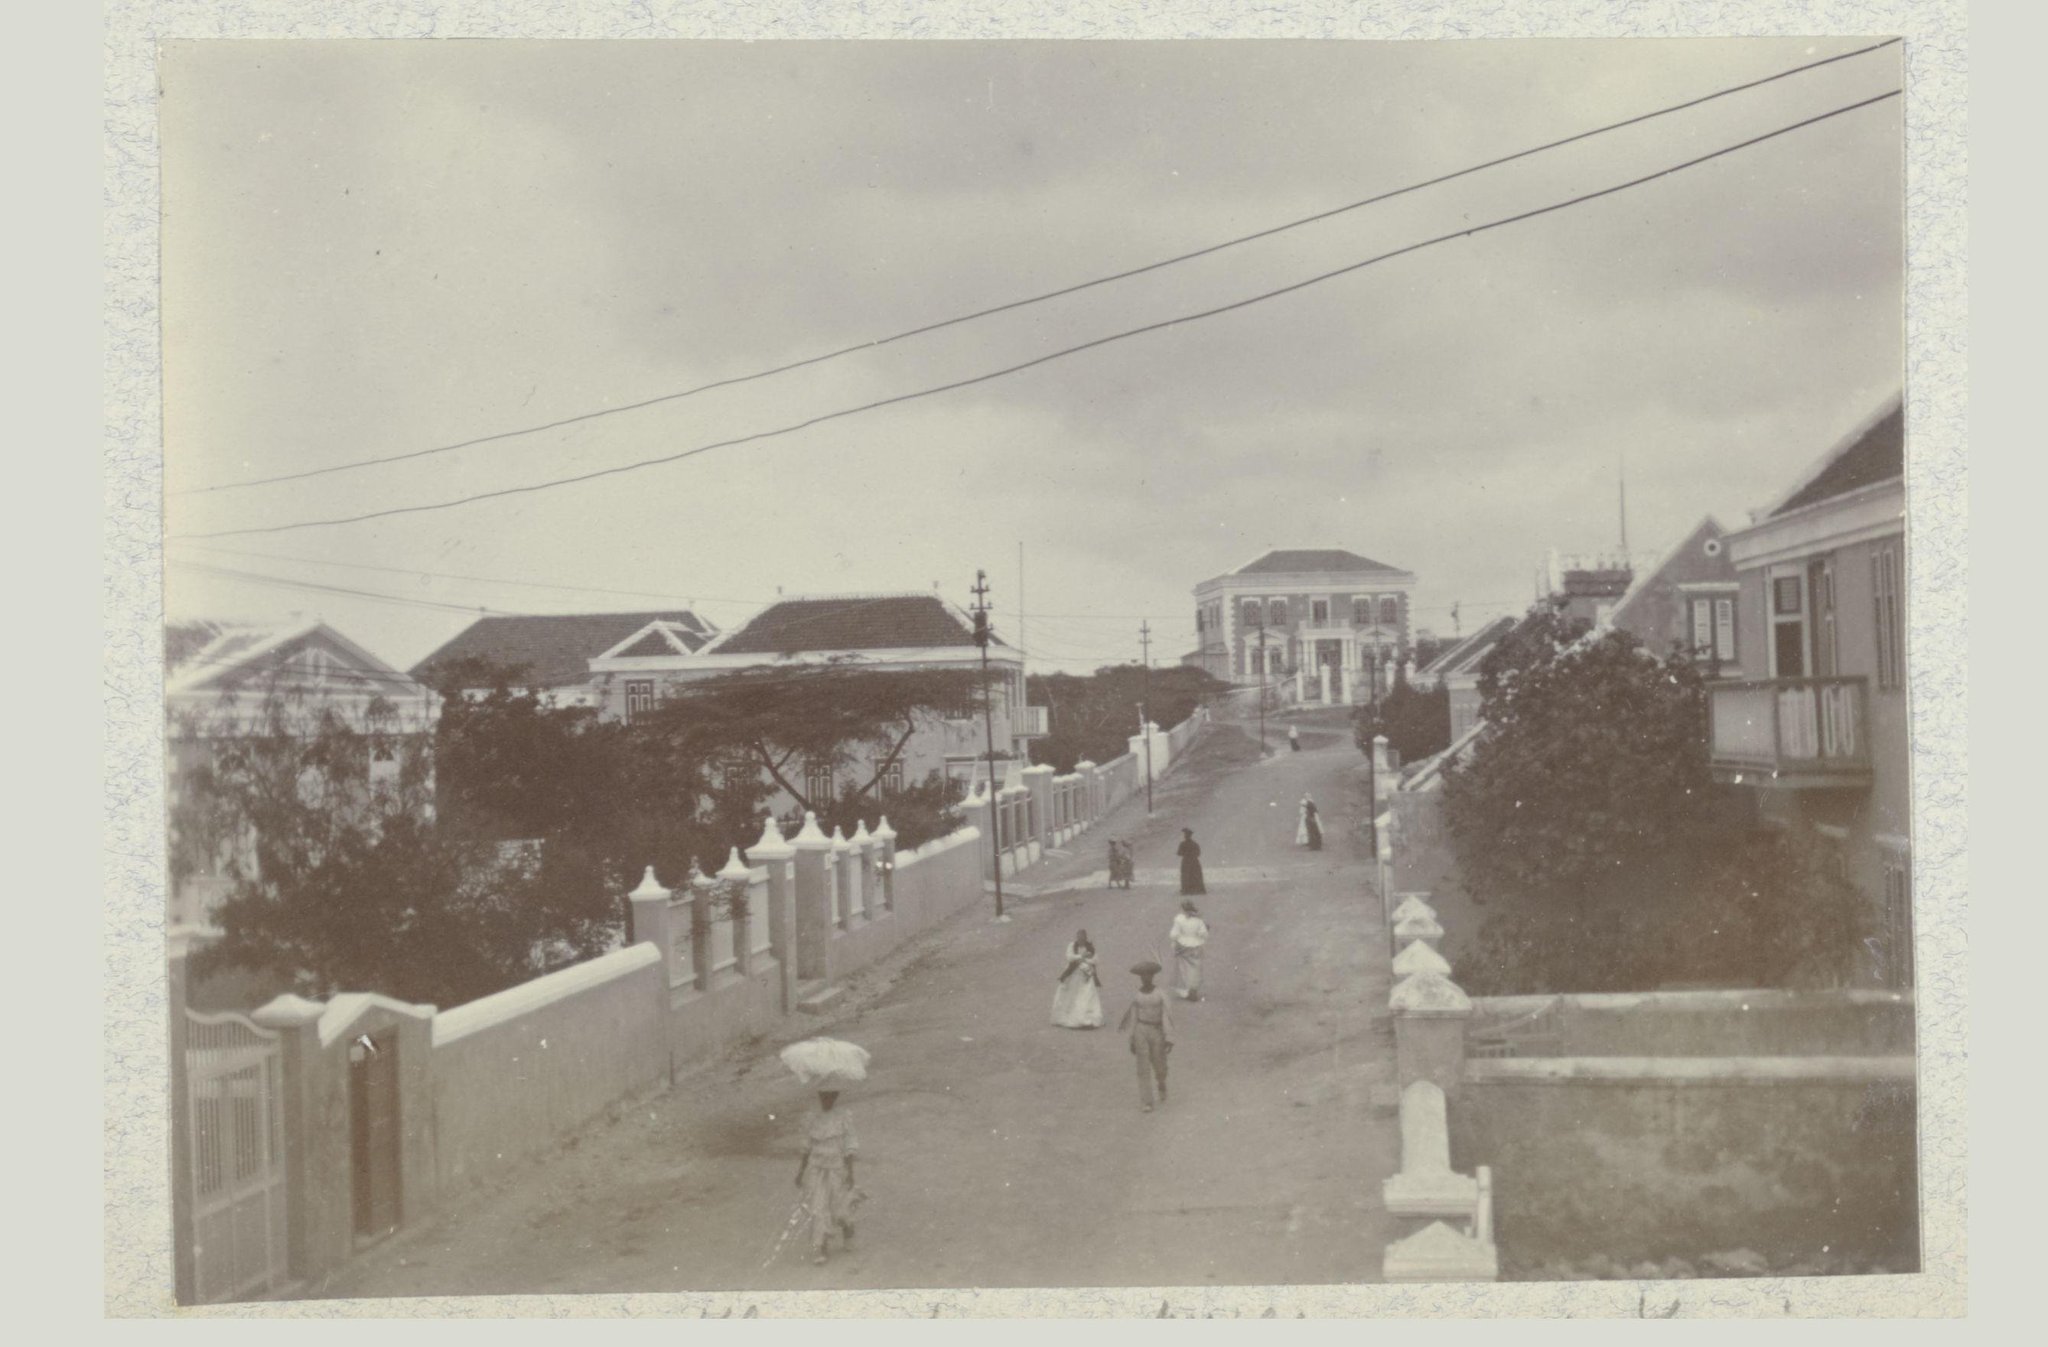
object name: photograph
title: Hoogstraat in Willemstad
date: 1906-1910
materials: photographic support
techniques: photography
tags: city-view in general; 'veduta'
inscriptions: inscription: ‘Hoogstraat Willemstad Juni 1910’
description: Gezicht in de Hoogstraat in Willemstad op Curaçao, juni 1910. Onderdeel van het fotoalbum van de familie Boom-Gonggrijp in Suriname en Curaçao.